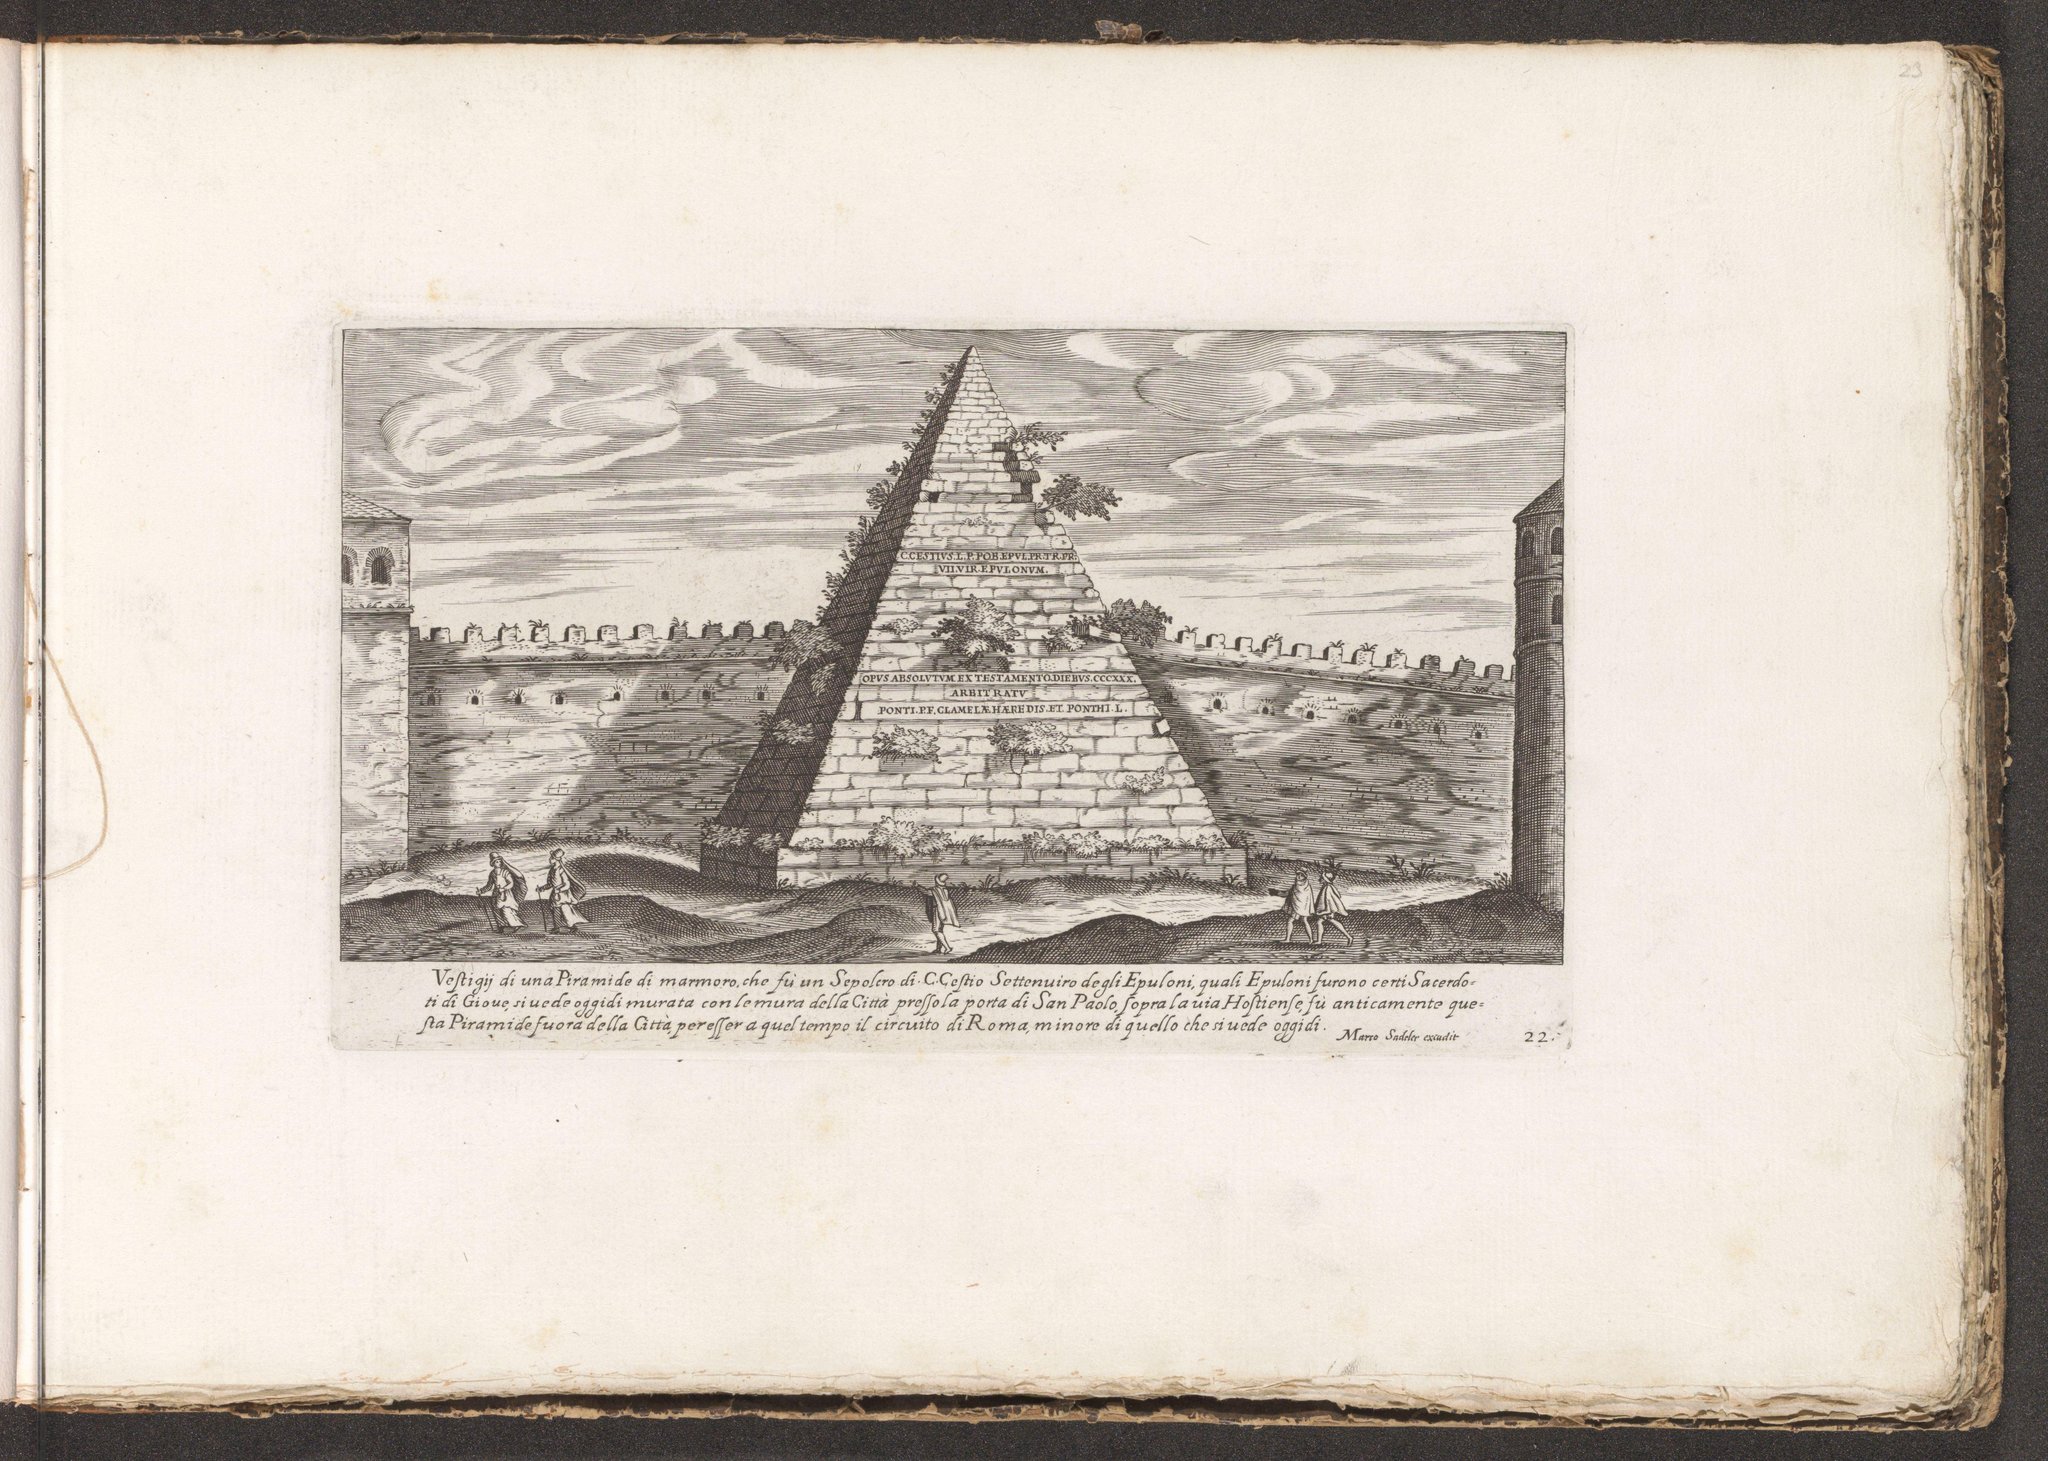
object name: album leaf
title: Vestigi delle antichita di Roma, Tivoli, Pozzuolo et altri luochi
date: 1680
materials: paper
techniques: engraving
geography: rome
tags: rome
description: De Piramide van Cestius, gebouwd als grafmonument voor Gaius Cestius Epulonius. De piramide is opgenomen in de Aureliaanse muur. In de ondermarge drie regels tekst in het Italiaans. De prent maakt deel uit van een album.